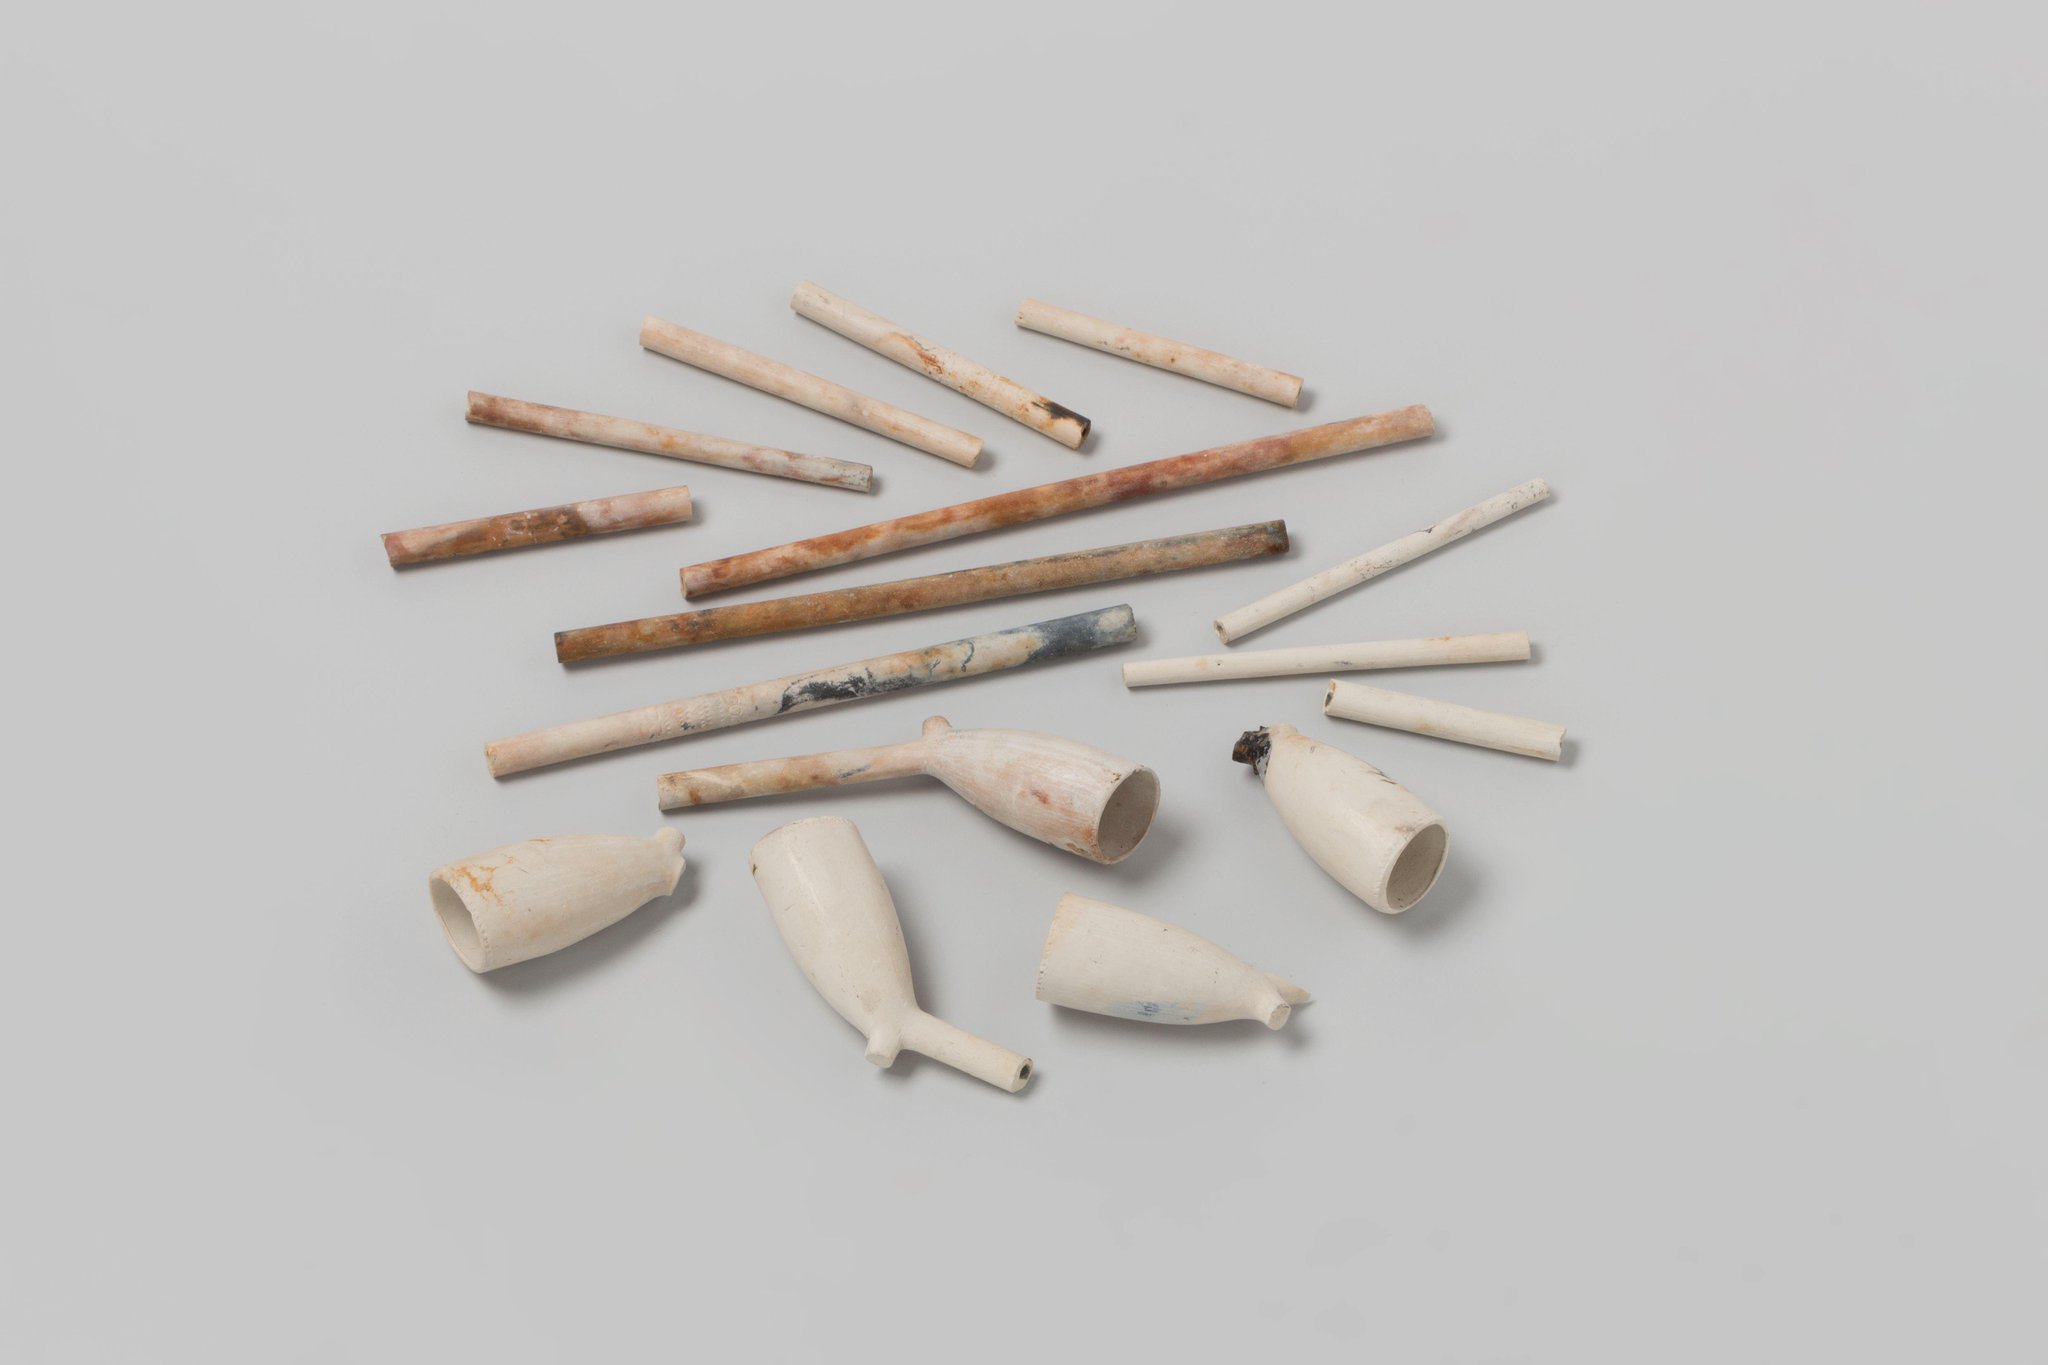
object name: pipe stem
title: Fragmenten van pijpen en pijpenstelen uit het wrak van de Oost-Indiëvaarder 't Vliegend Hart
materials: clay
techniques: firing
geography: gouda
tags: 't vliegend hart (schip), verenigde oostindische compagnie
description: Vijf koppen en 11 losse stukken van stelen van aarden Goudse pijpen. Van de koppen dragen 2 het hielmerk gekroonde WS (waarvan éen nog een stuk steel heeft), is van éen het hielmerk onleesbaar en van twee het hielmerk de gekroonde 67 (van deze laatste twee heeft éen nog een stuk steel). De losse stukken steel zijn deels versierd en blauw en rood verkleurd. Fragments of bowls and stems.